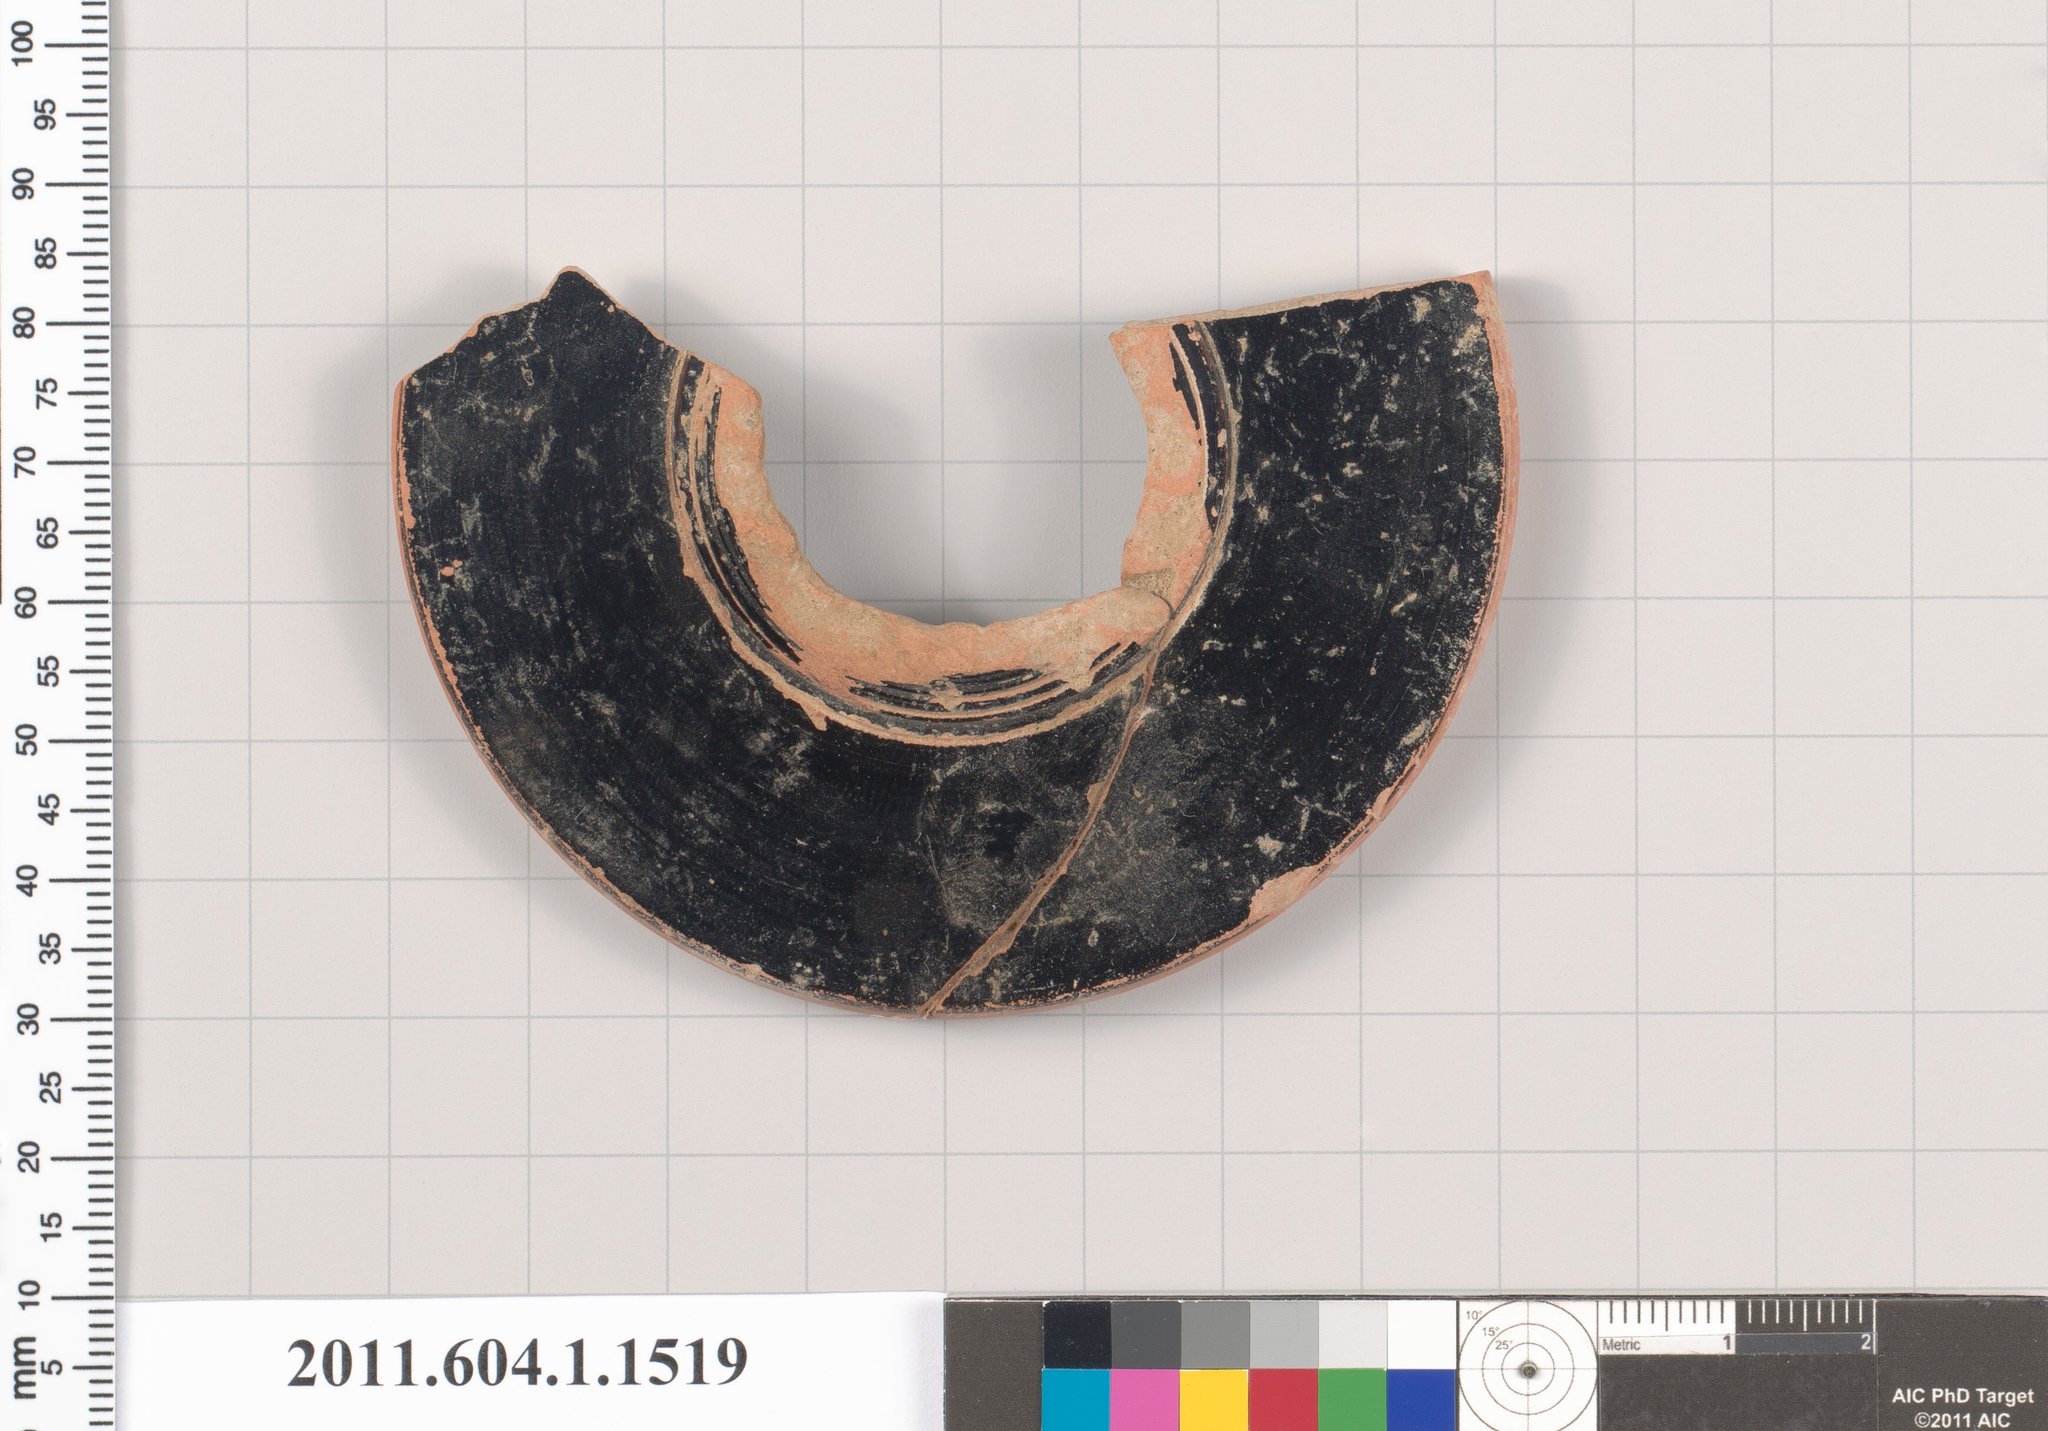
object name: kylix fragment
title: Terracotta fragment of a kylix (drinking cup)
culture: greek, attic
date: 500-401 BCE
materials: terracotta